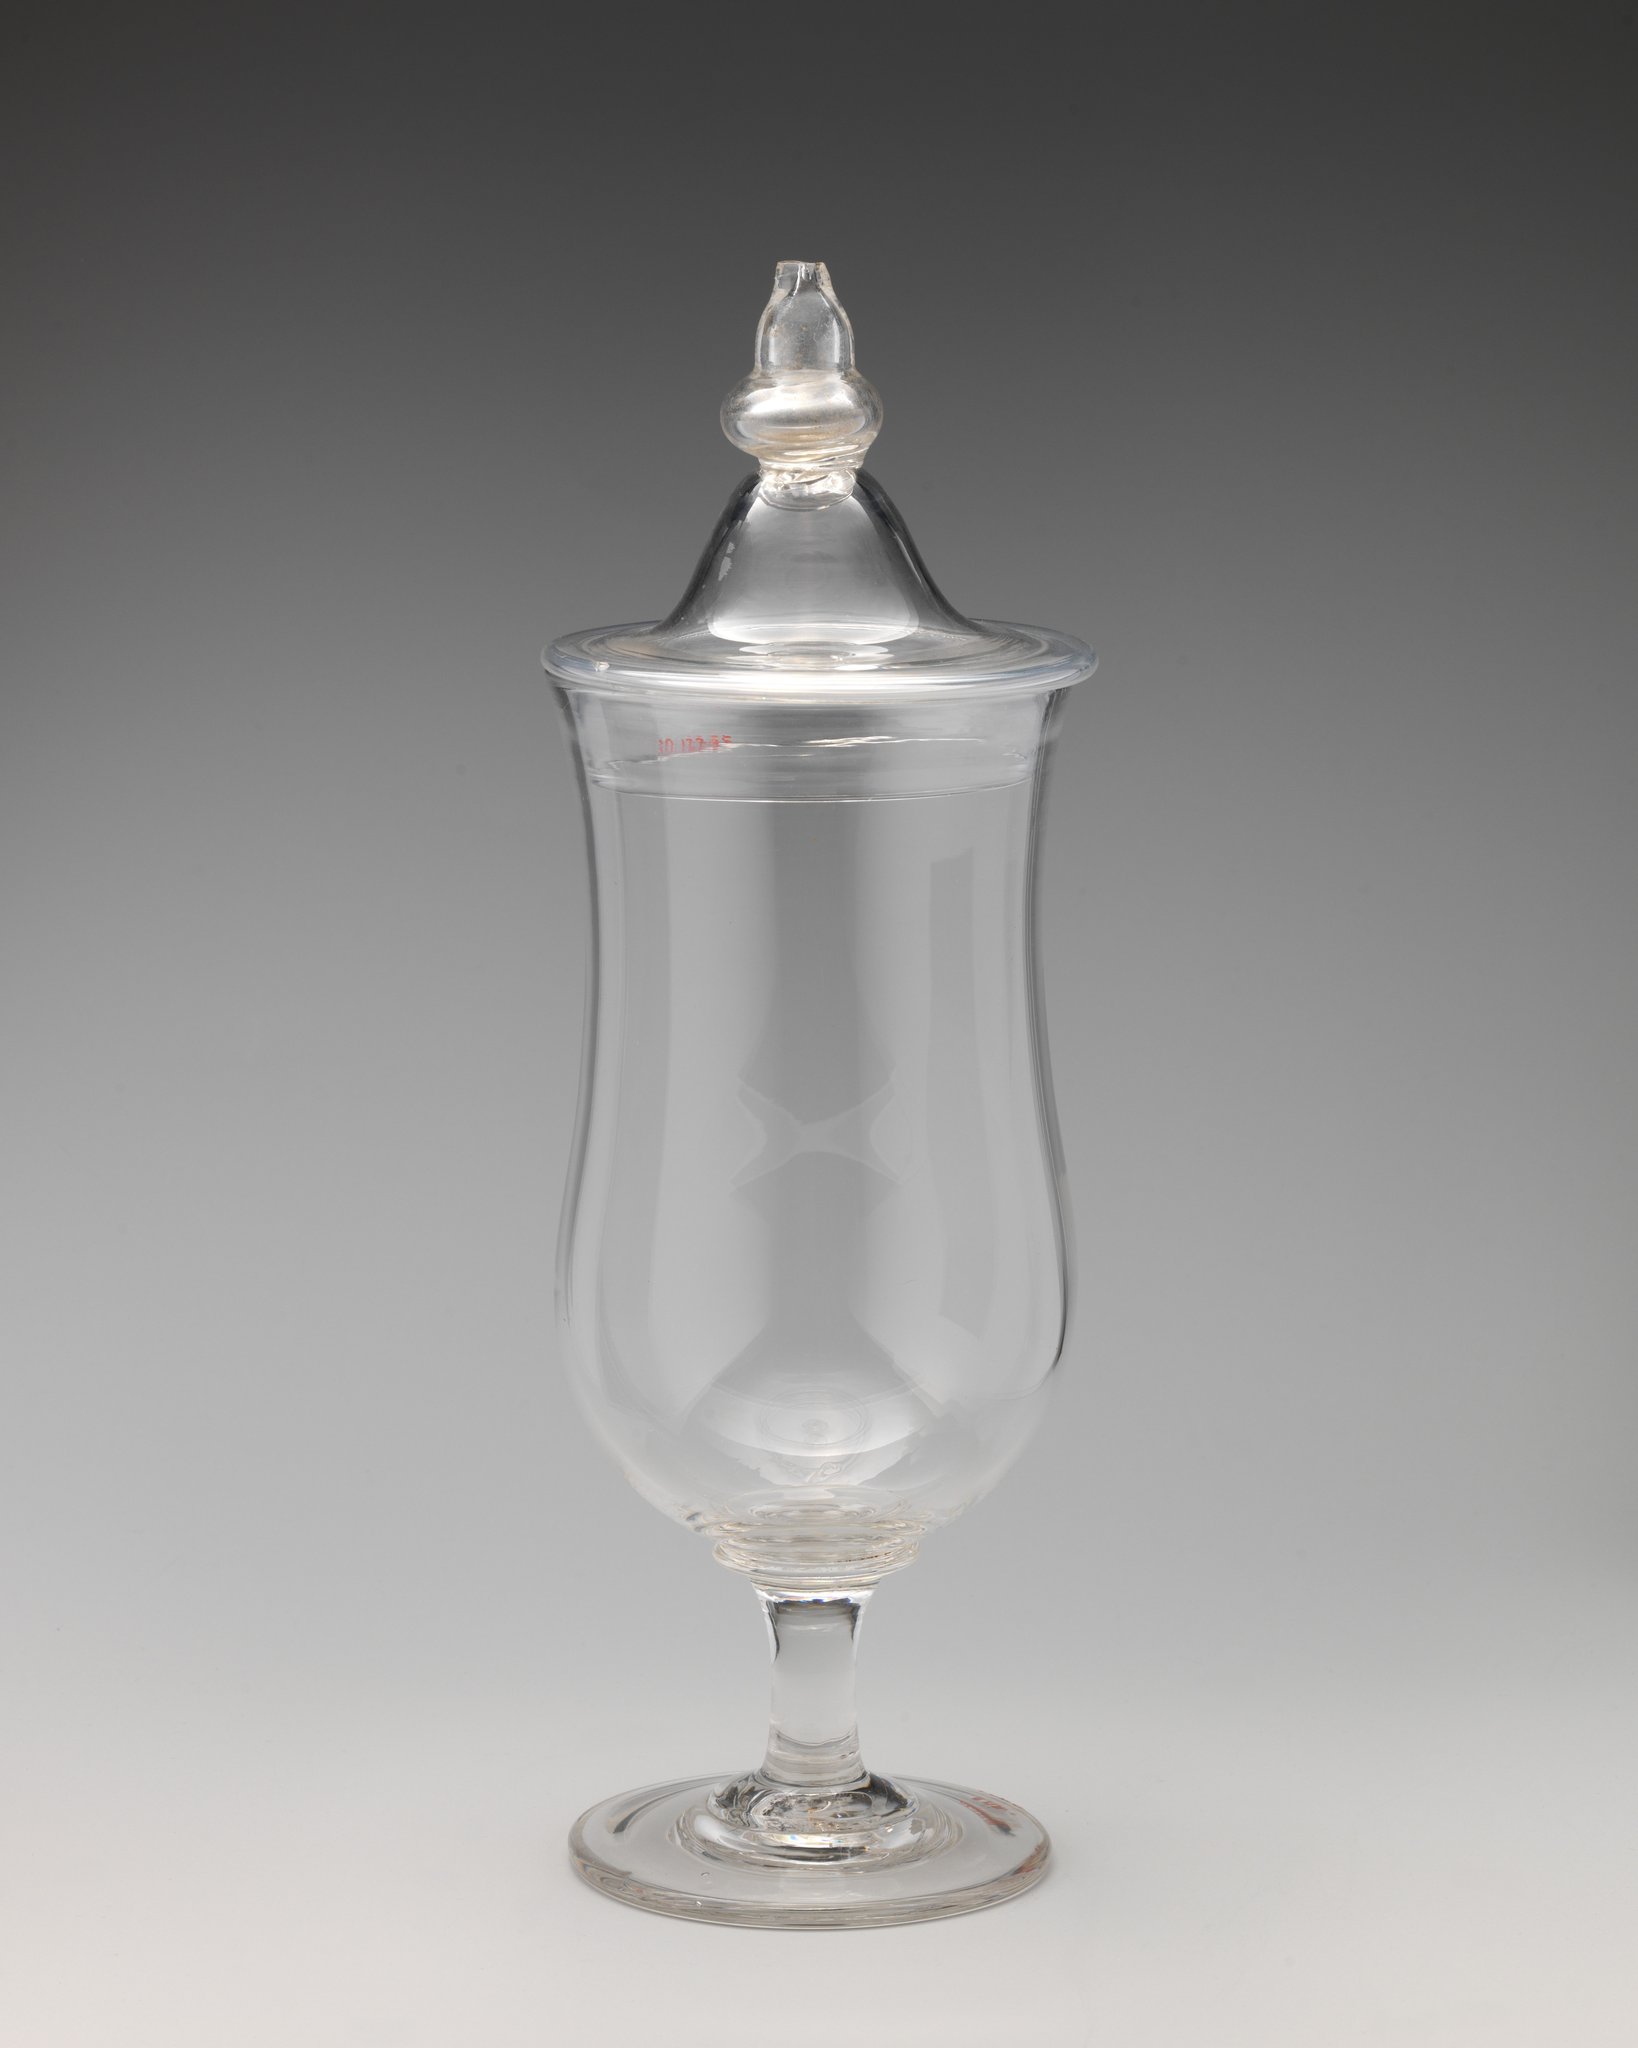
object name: jar with cover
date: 1767-1800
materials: glass